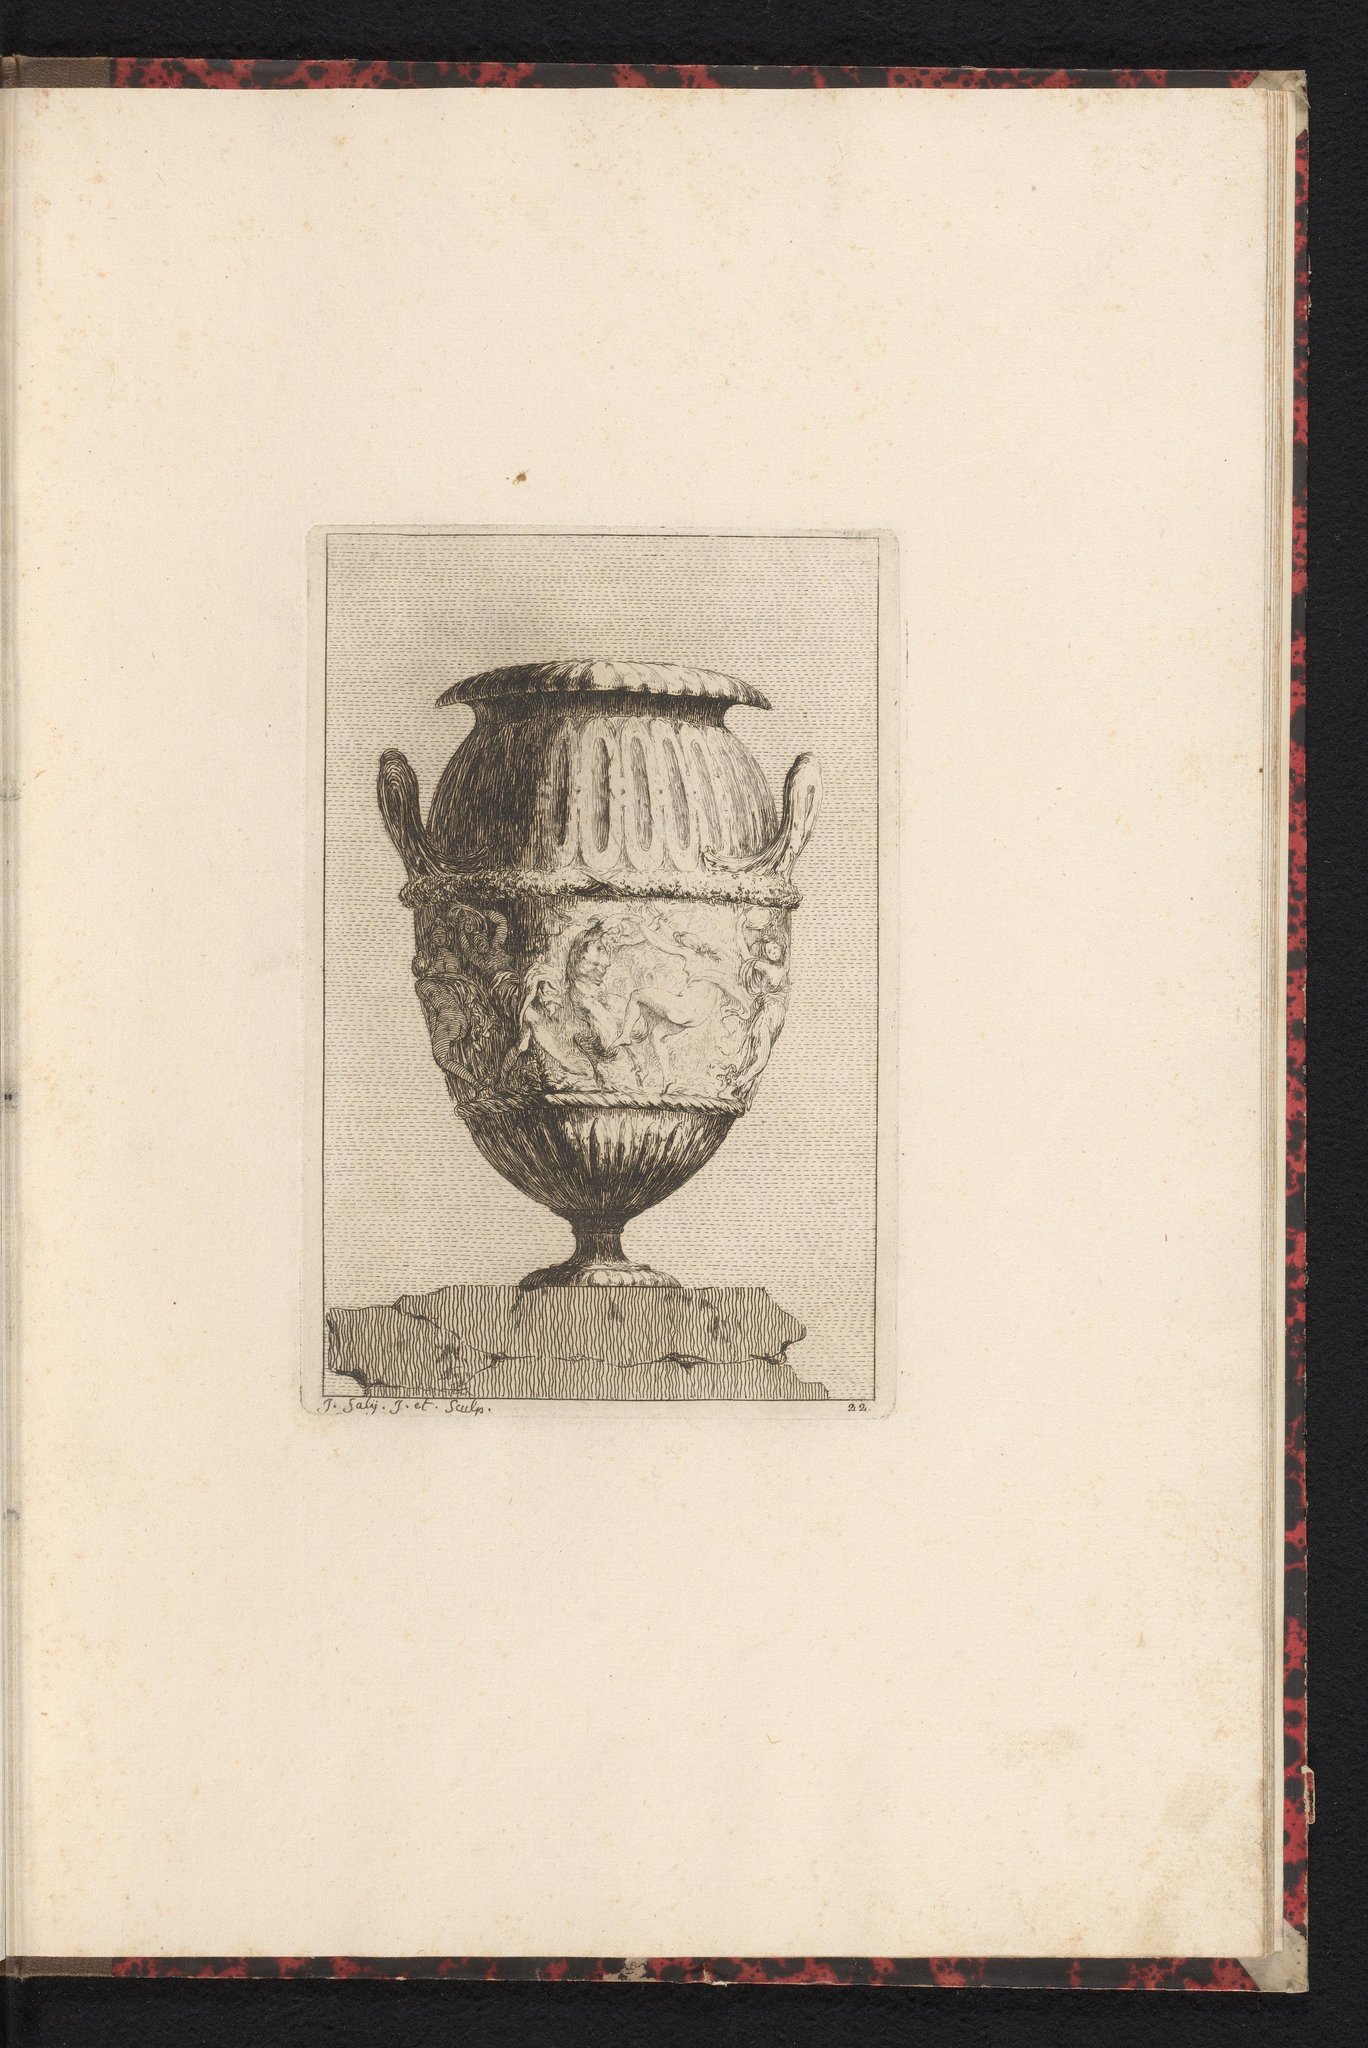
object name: ornament print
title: Vasa a se inventa atq. studii causa delin. et incisa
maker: jacques francois joseph saly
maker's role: print maker, sculptor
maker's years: 1717-1776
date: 1746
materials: paper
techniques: etching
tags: maenad(s), female bacchant(es), thiasos, i.e. bacchus' revel-rout, bacchanal without bacchus, satyr(s) (in general), garden vase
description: Deze prent maakt deel uit van een album.